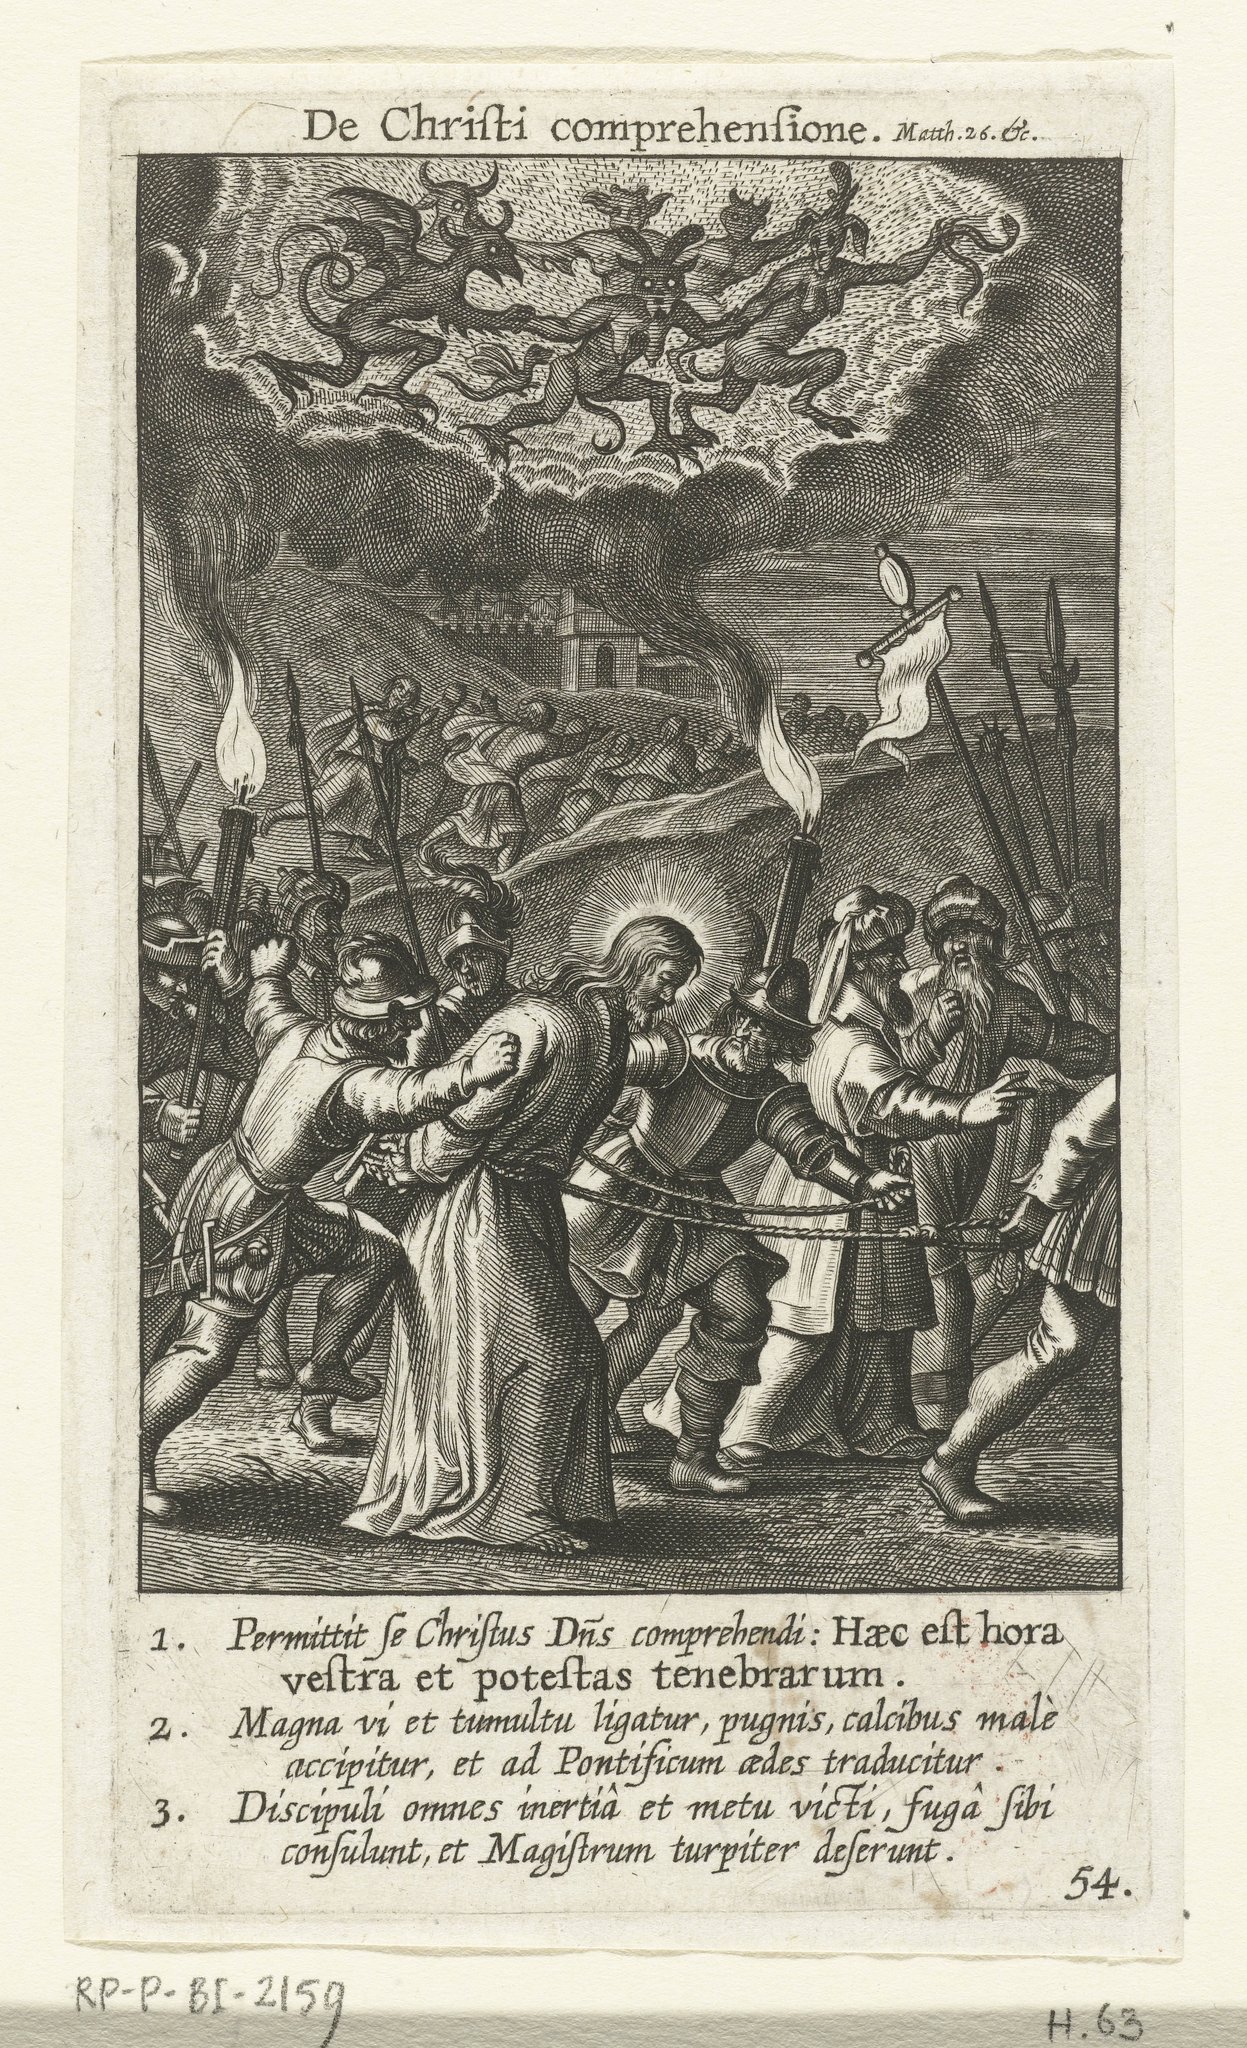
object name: print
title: Vitae passionis et mortis Jesu Christ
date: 1590-1622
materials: paper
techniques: engraving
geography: antwerp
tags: christ is led away ~ garden of gethsemane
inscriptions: collector's mark: Lugt 240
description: Prent uit: Joannes Bourgois, Vitae passionis et mortis Jesu Christi Somini nostri mysteria, Antwerpen Hendrick Aertssens, 1622, afb. 54